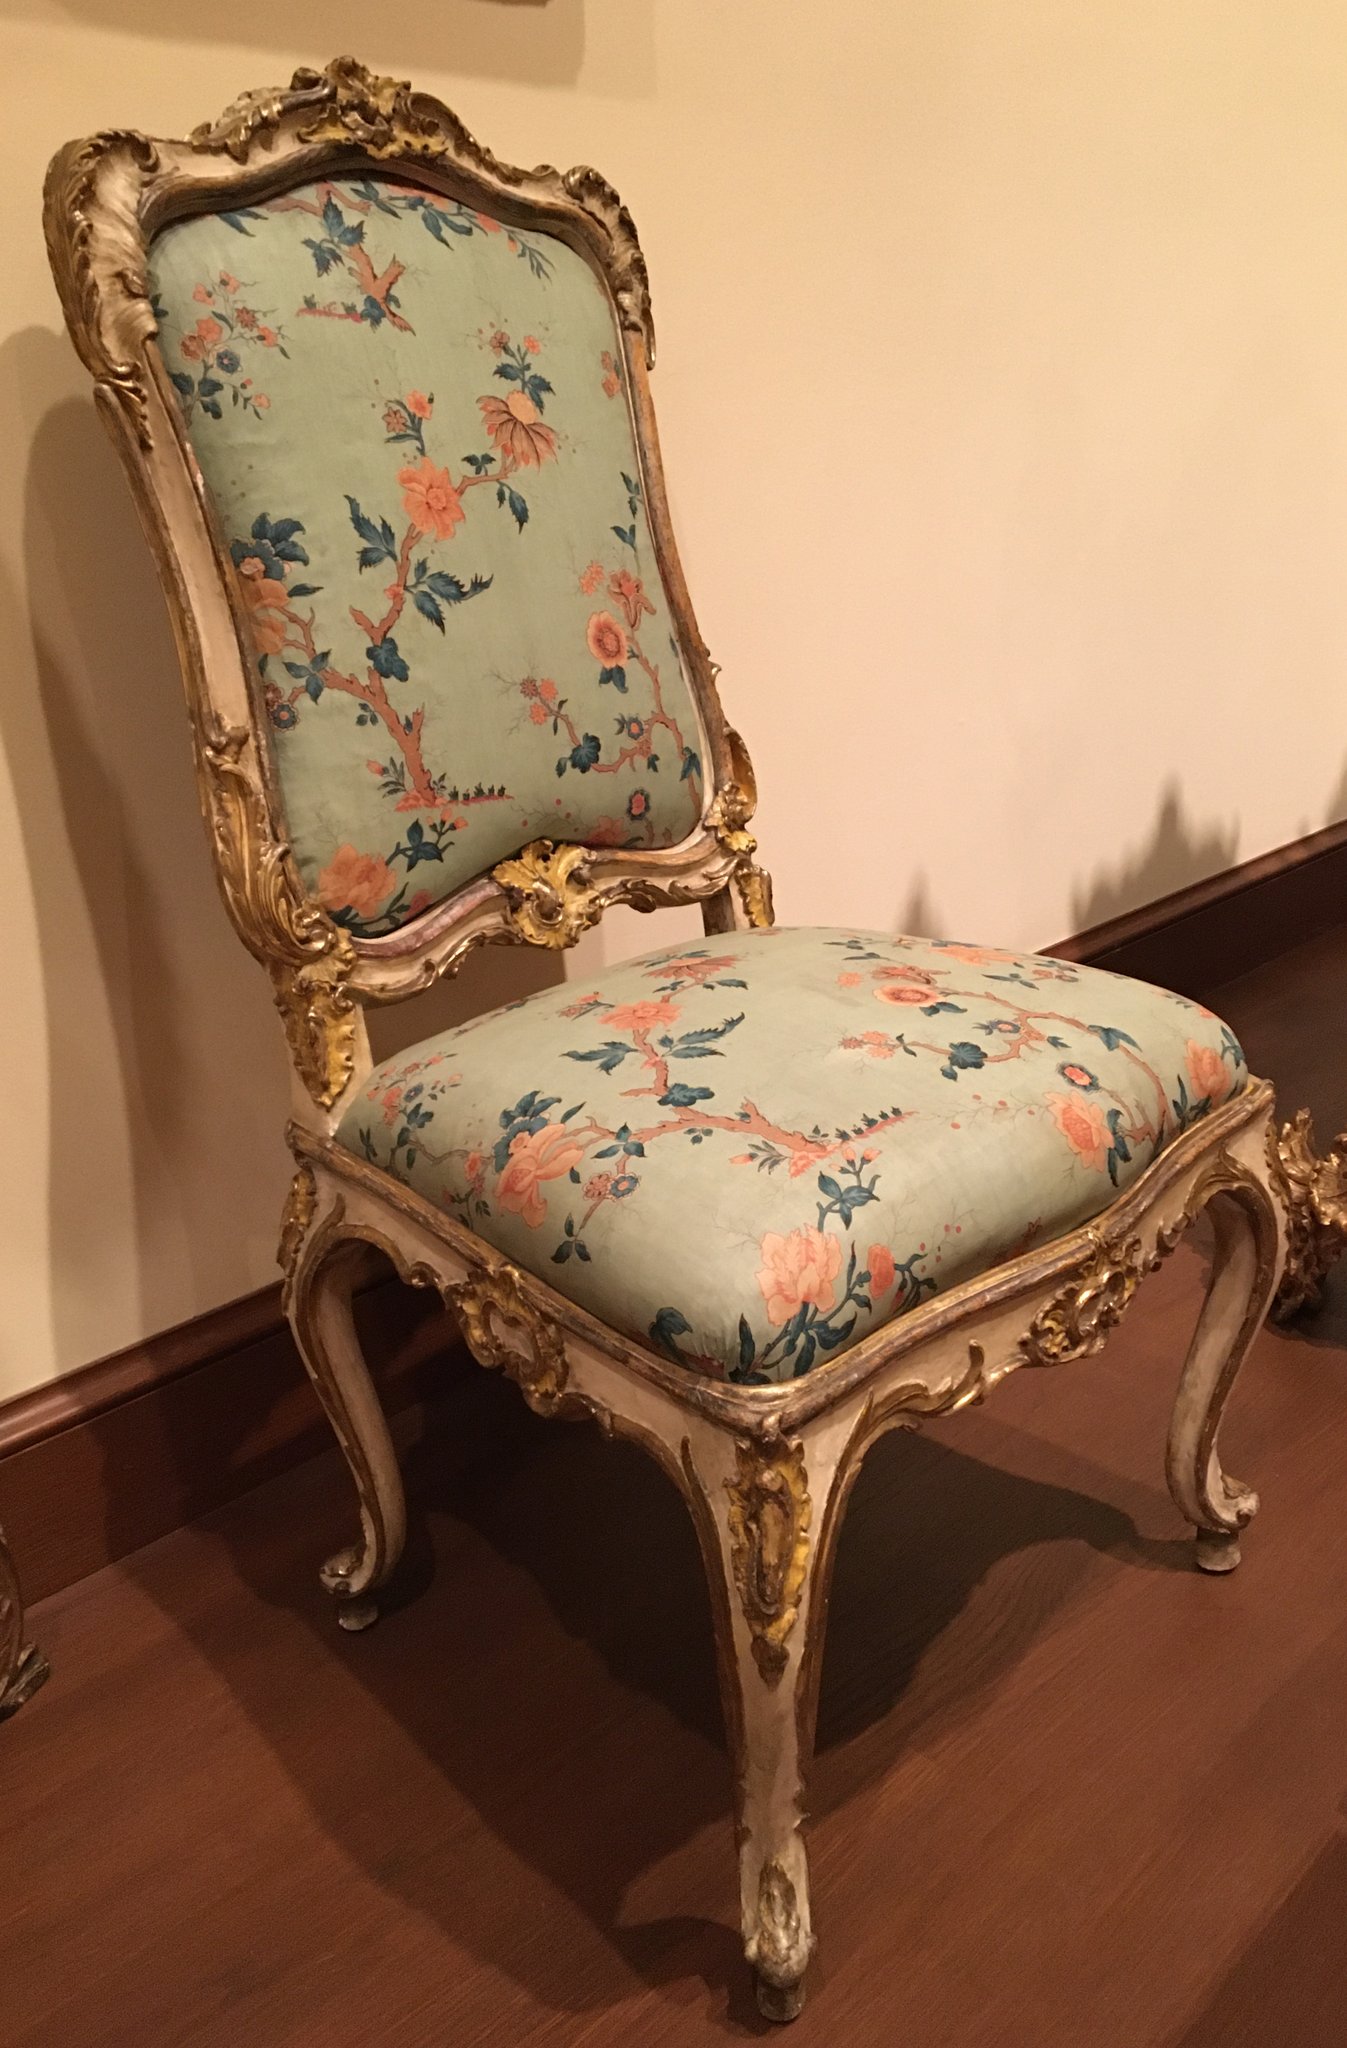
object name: side chair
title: Side chair (set of four)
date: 1750-1760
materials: wood, cotton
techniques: carving, gilding, painting, printing, silvered